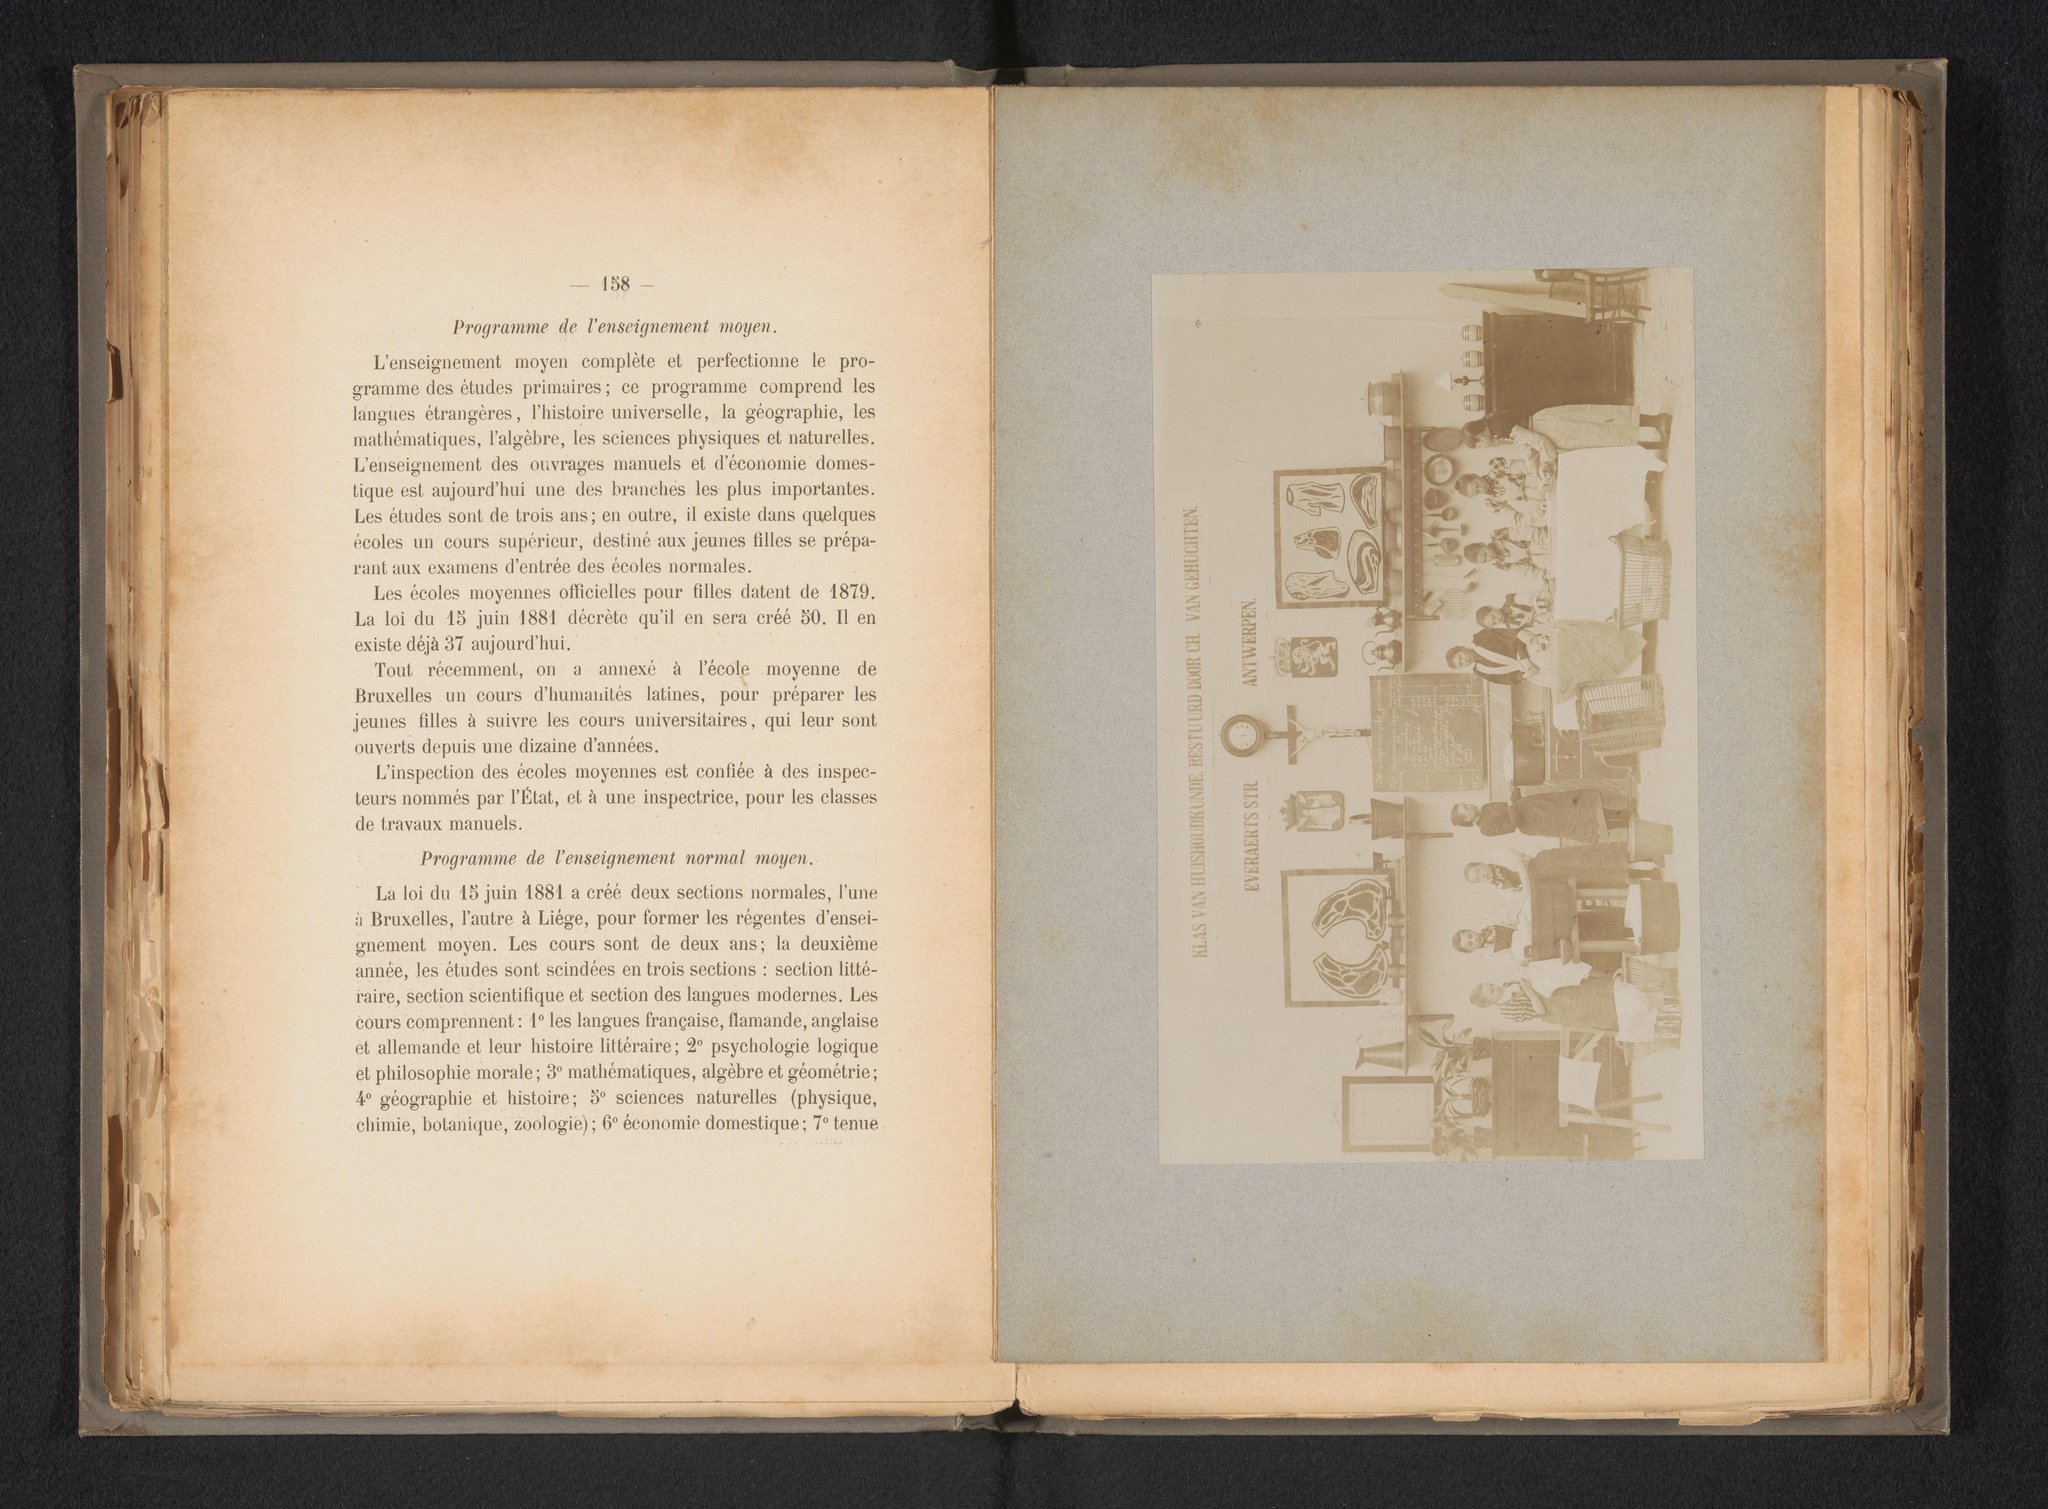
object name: page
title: Gezicht op een schoolklas van huishoudkunde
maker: Anonymous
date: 1888-1893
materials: photographic support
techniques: collodion silver print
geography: antwerp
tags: laundering, household chores, elementary school; class, form, antwerp